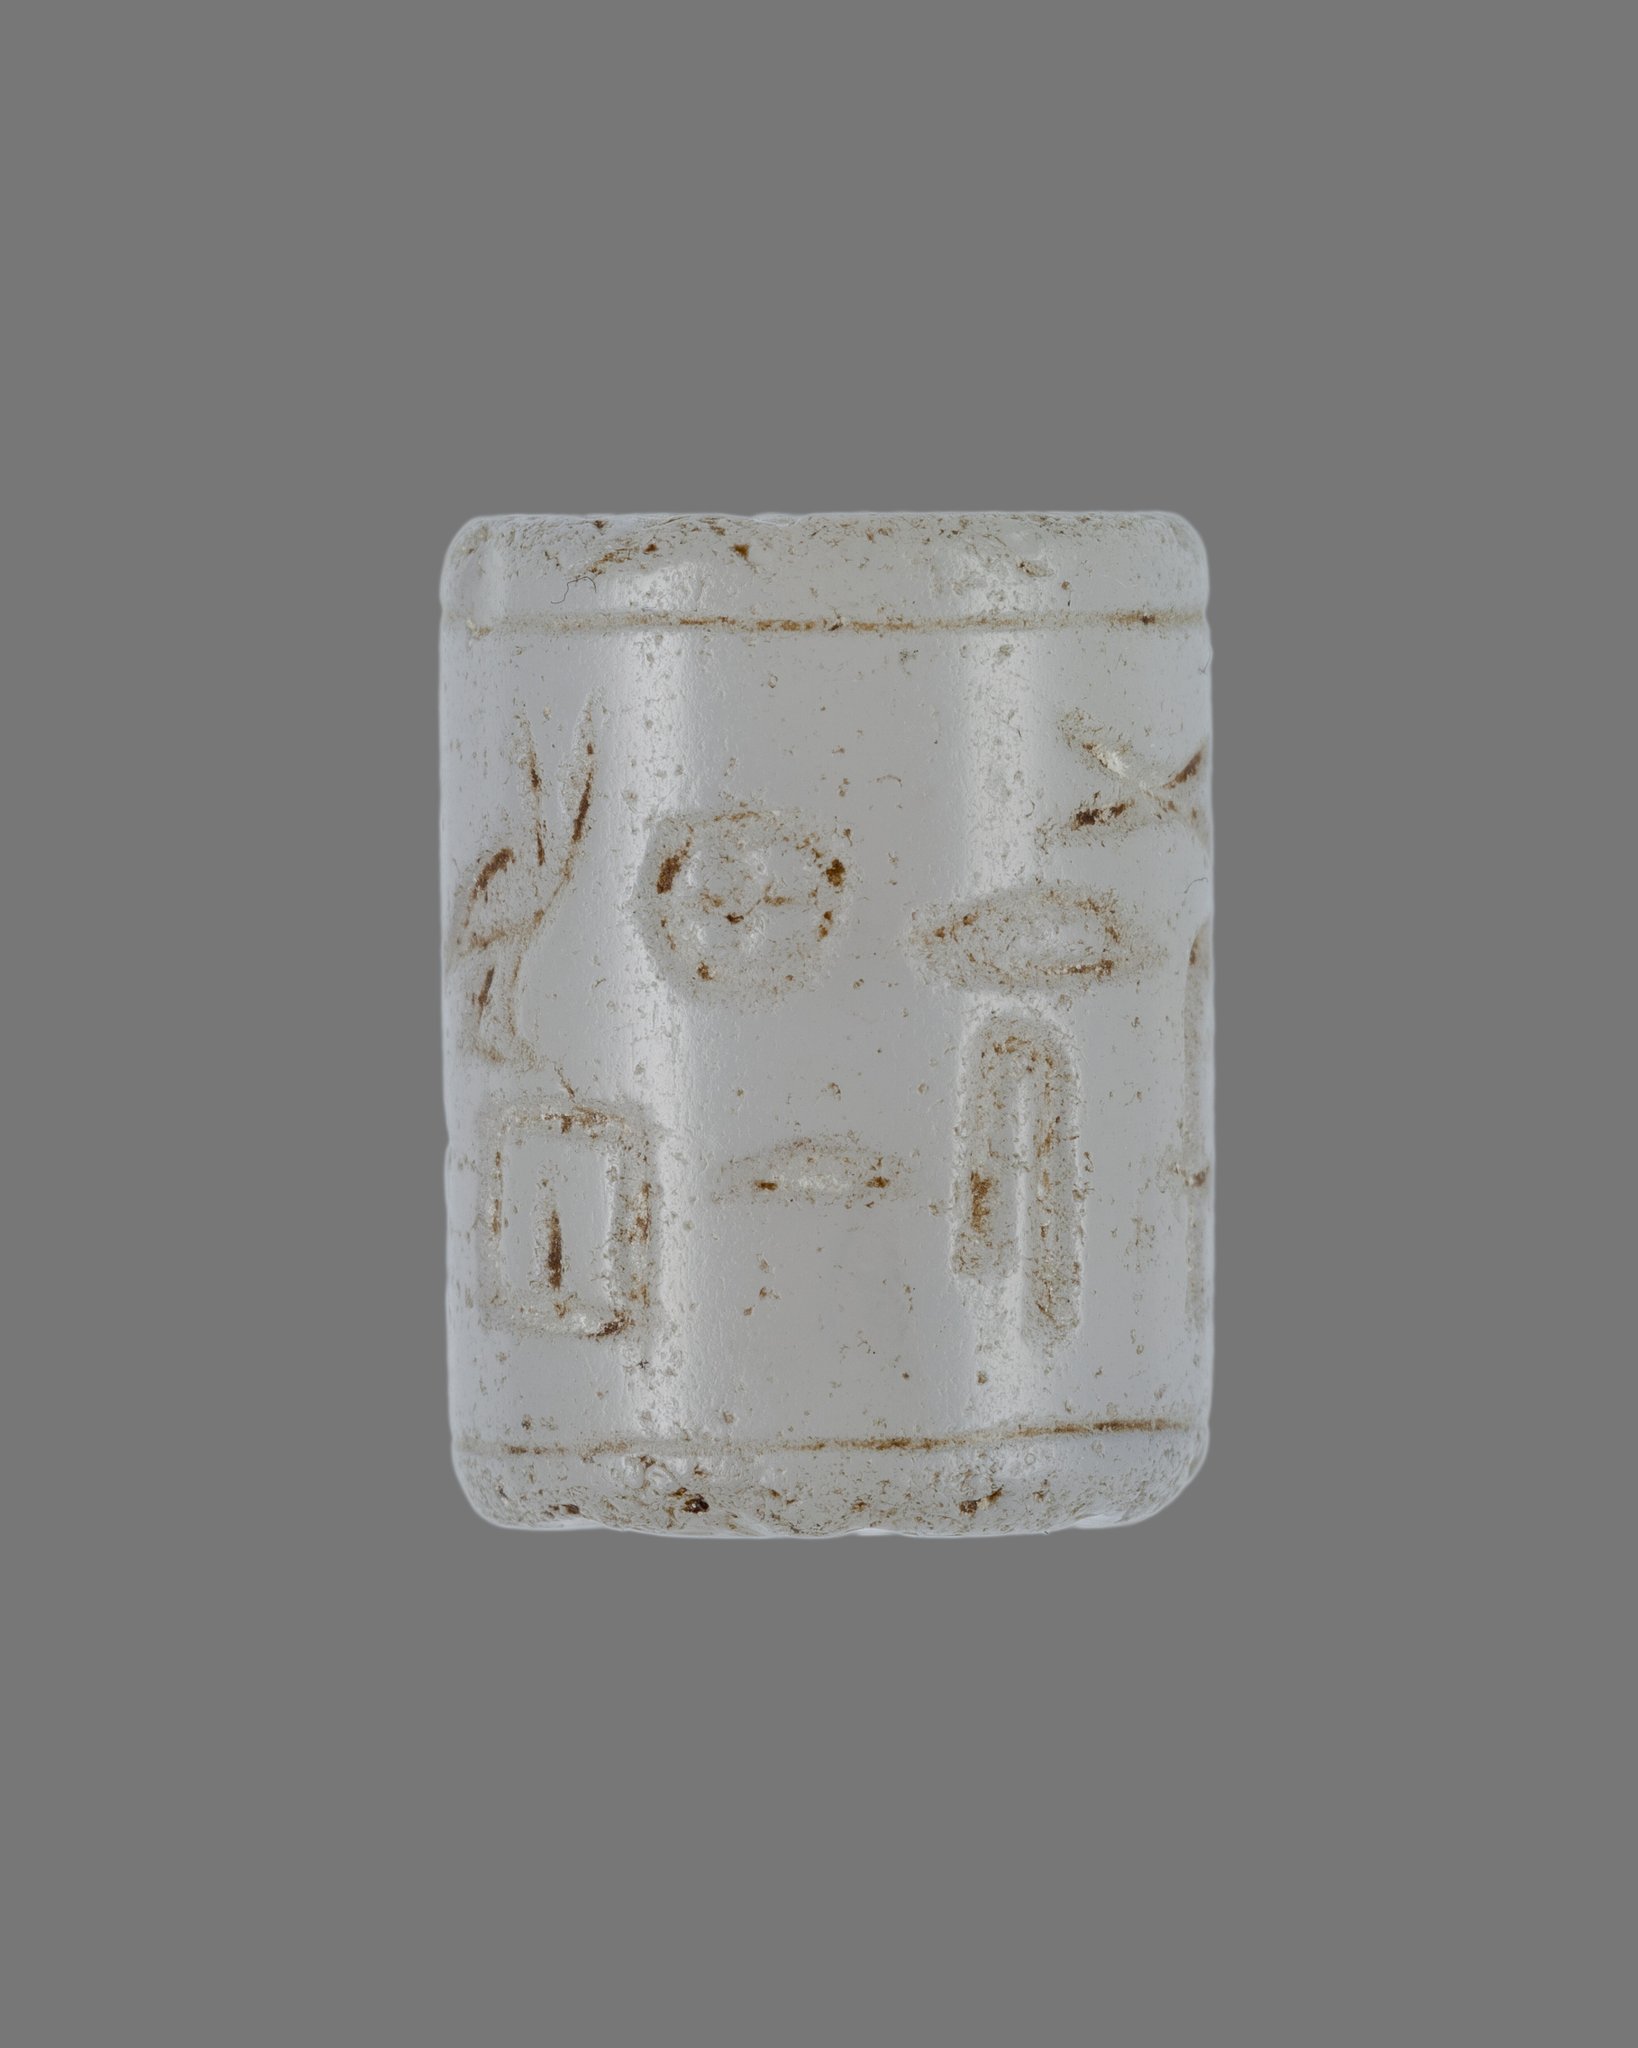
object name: cylinder seal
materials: stone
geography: egypt